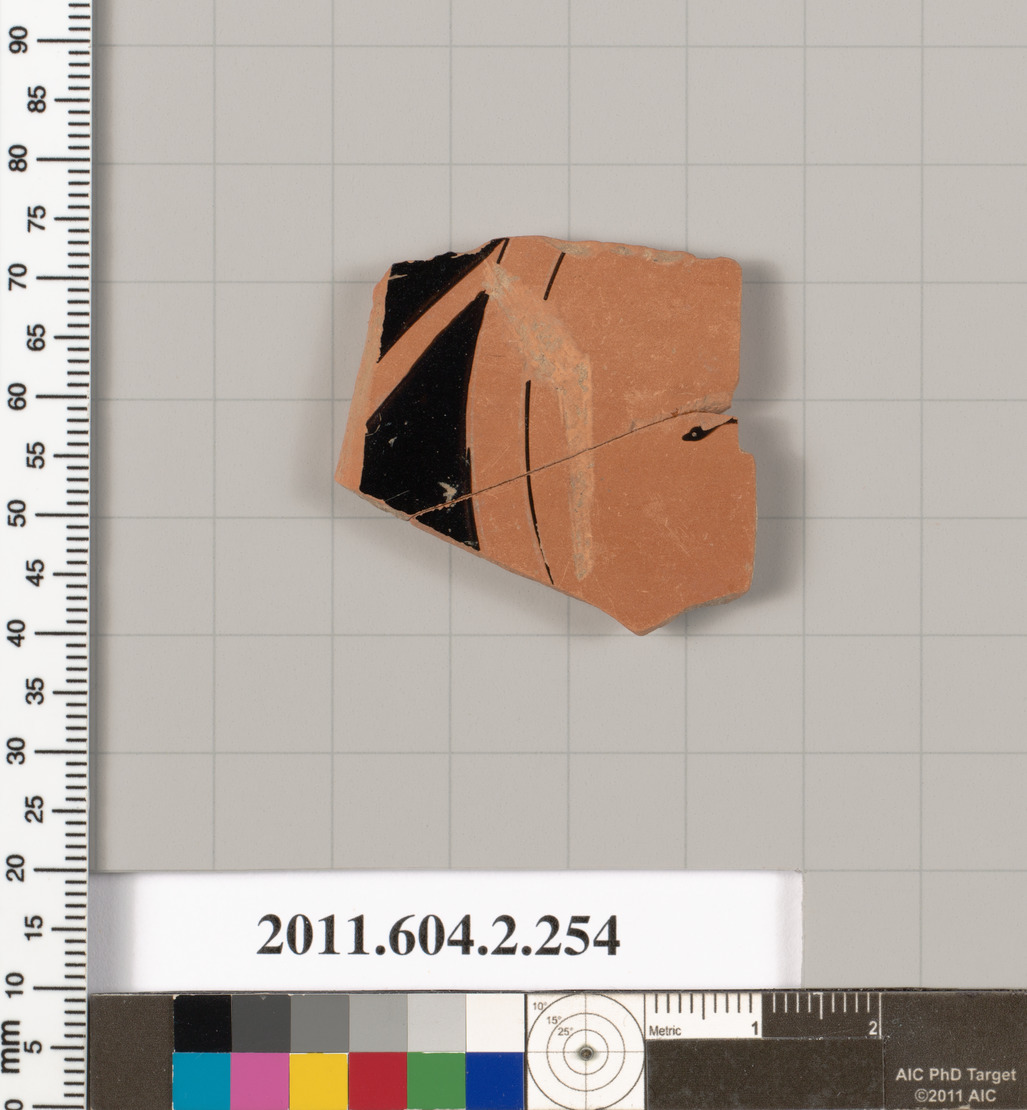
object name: stamnos fragment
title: Terracotta fragment of a stamnos (jar)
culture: greek, attic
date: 500-476 BCE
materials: terracotta